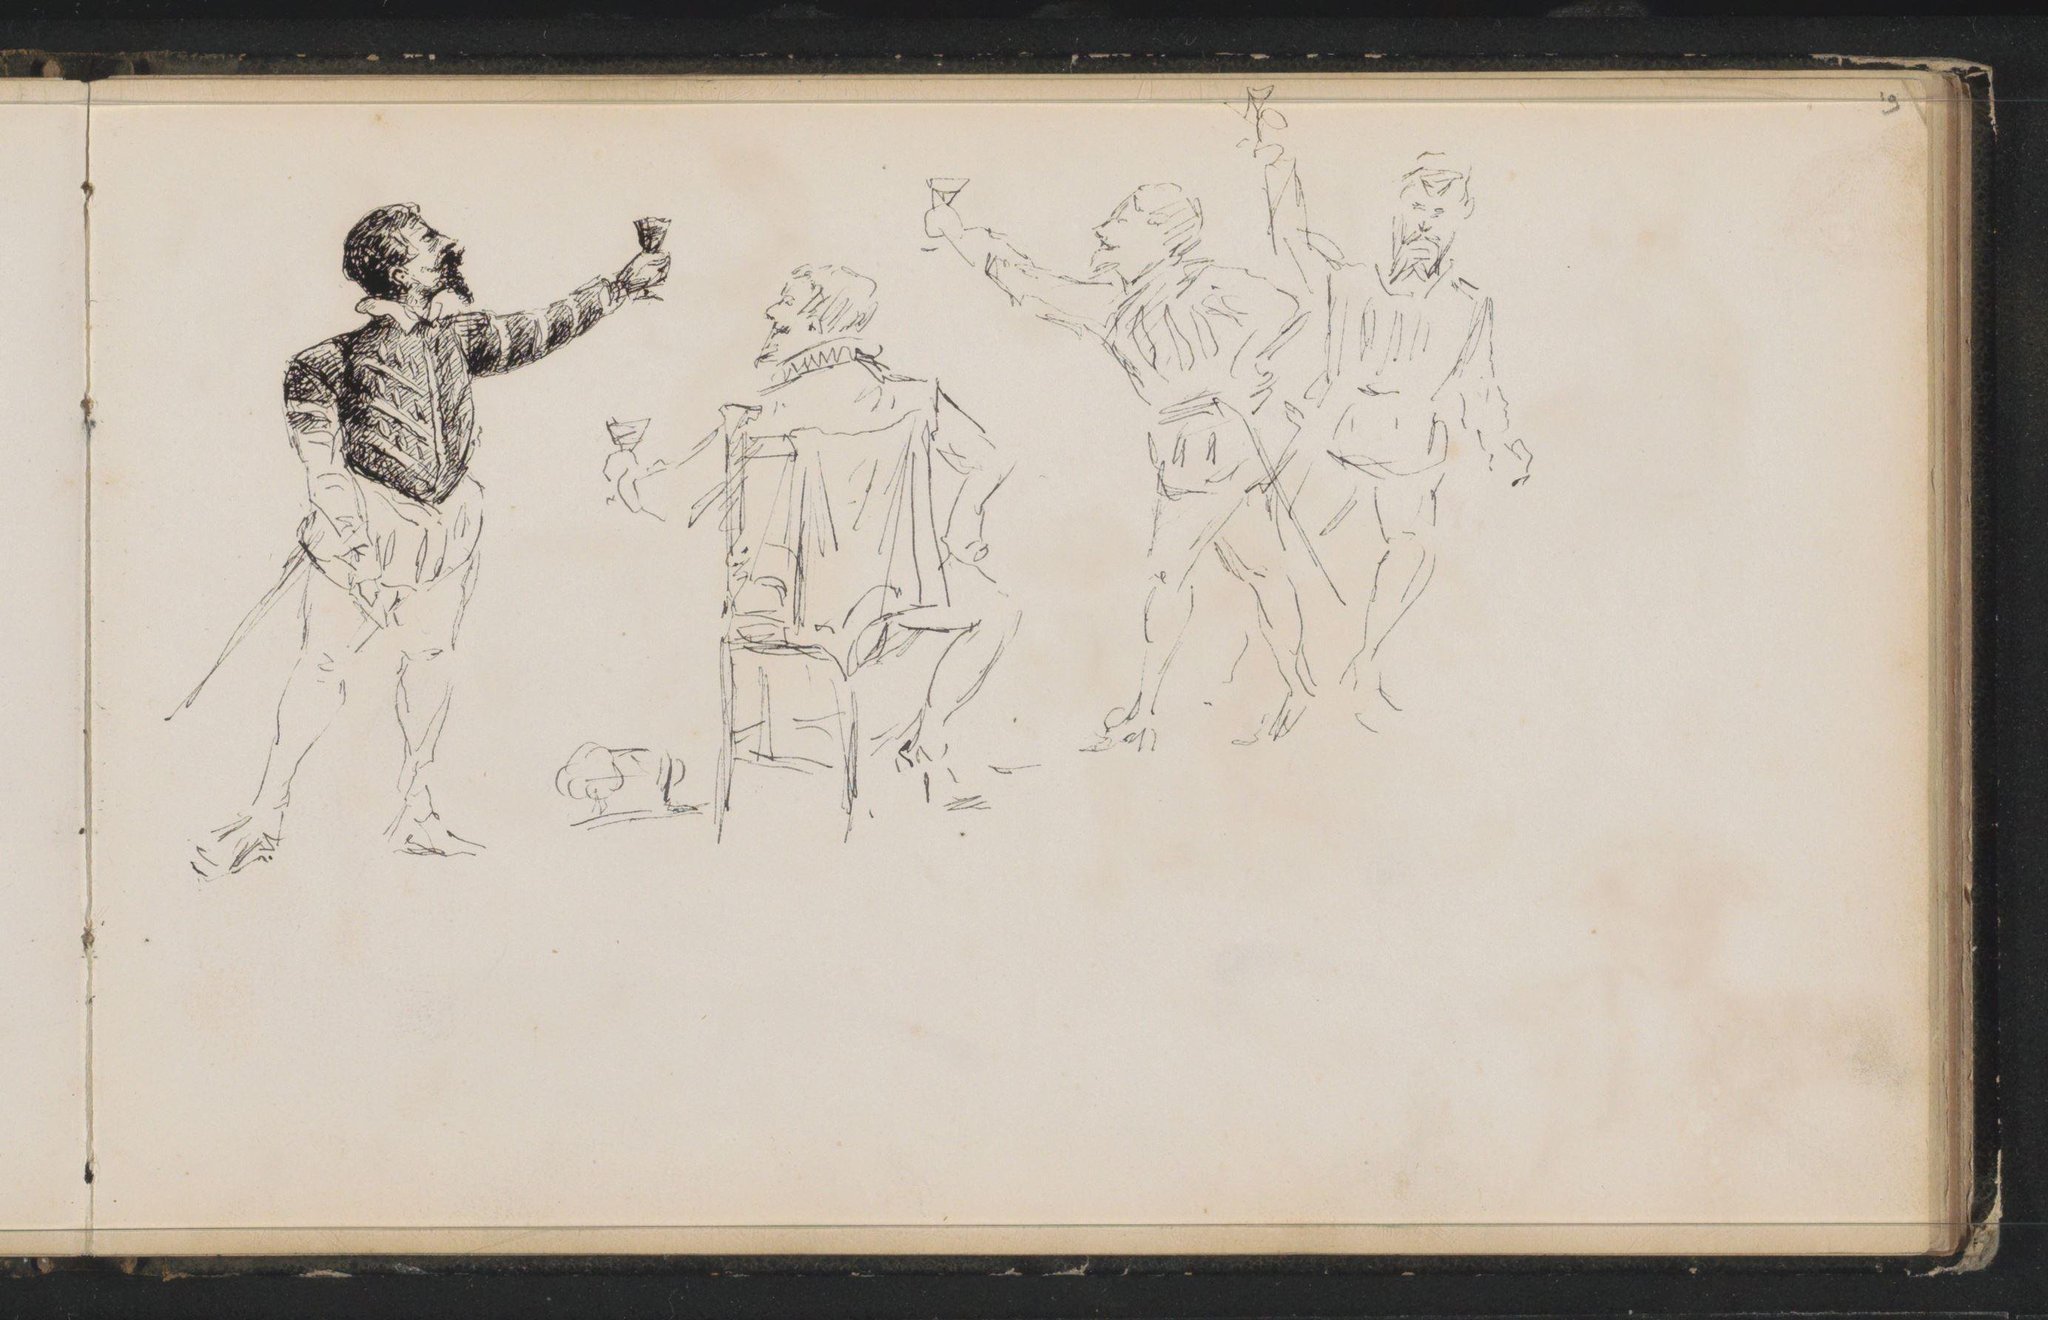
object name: sketchbook leaf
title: Vier militairen die het glas heffen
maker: marius bauer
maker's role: draughtsman, print maker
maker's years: 1867-1932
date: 1812-1880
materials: paper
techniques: pen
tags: hacking and thrusting weapons, arm raised upward (+ indicating, pointing at), historical costume, glass of wine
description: De figuren dragen zeventiende-eeuws kostuum en zwaarden. Pagina 19 uit een schetsboek met 34 bladen.